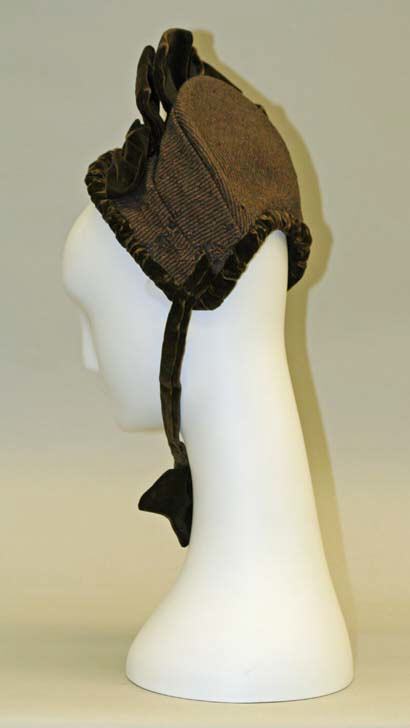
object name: bonnet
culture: american or european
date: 1880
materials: silk